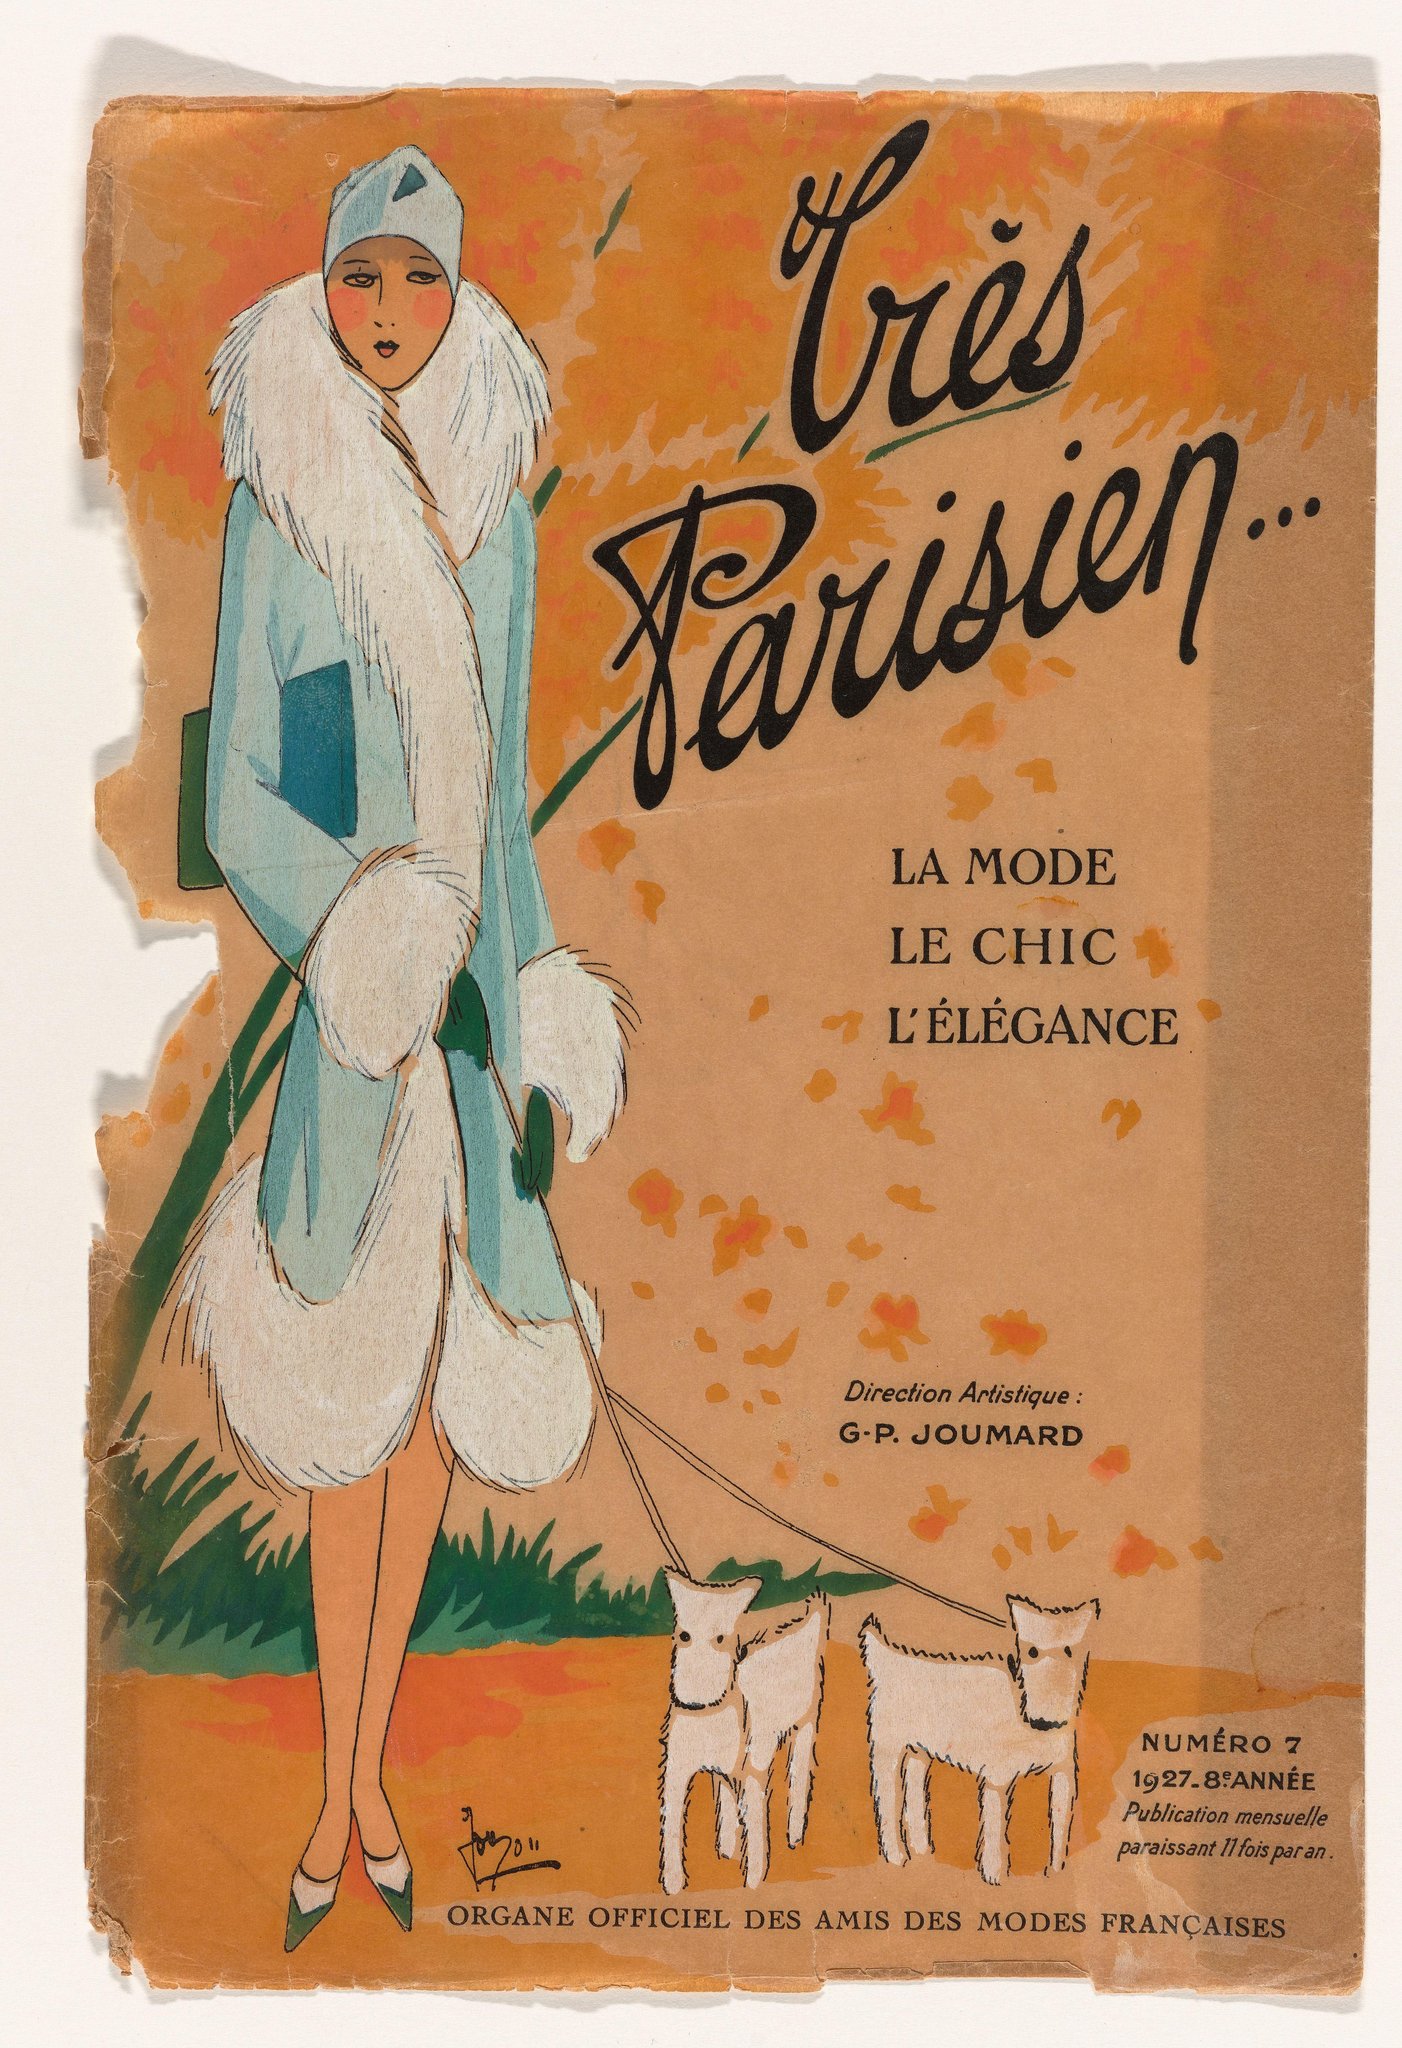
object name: fashion print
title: Très Parisien, 1927, No. 7 : La mode le chic l'éléganc (...)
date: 1927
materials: paper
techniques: hand coloring, letterpress printing, lithography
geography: paris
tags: bag (handbag) (+ women's clothes), coat (+ fur used for clothes), coat (+ women's clothes), head-gear (+ women's clothes), fashion plates, walking the dog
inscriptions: inscription: ‘Direction Artistique: G.P. JOUMARD / NUMÉRO 7 1927 _ 8e ANNÉE Publication mensuelle paraissant 11 fois par an. / ORGANE OFFICIEL DES AMIS DES MODES FRANÇAISES’, title: ‘Très Parisien... / LA MODE / LE CHIC / L'ÉLÉGANCE’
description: Omslag van het modetijdschrift Très Parisien (1920-1936). Vrouw in een mantel afgezet met bont. Twee honden aan de lijn.